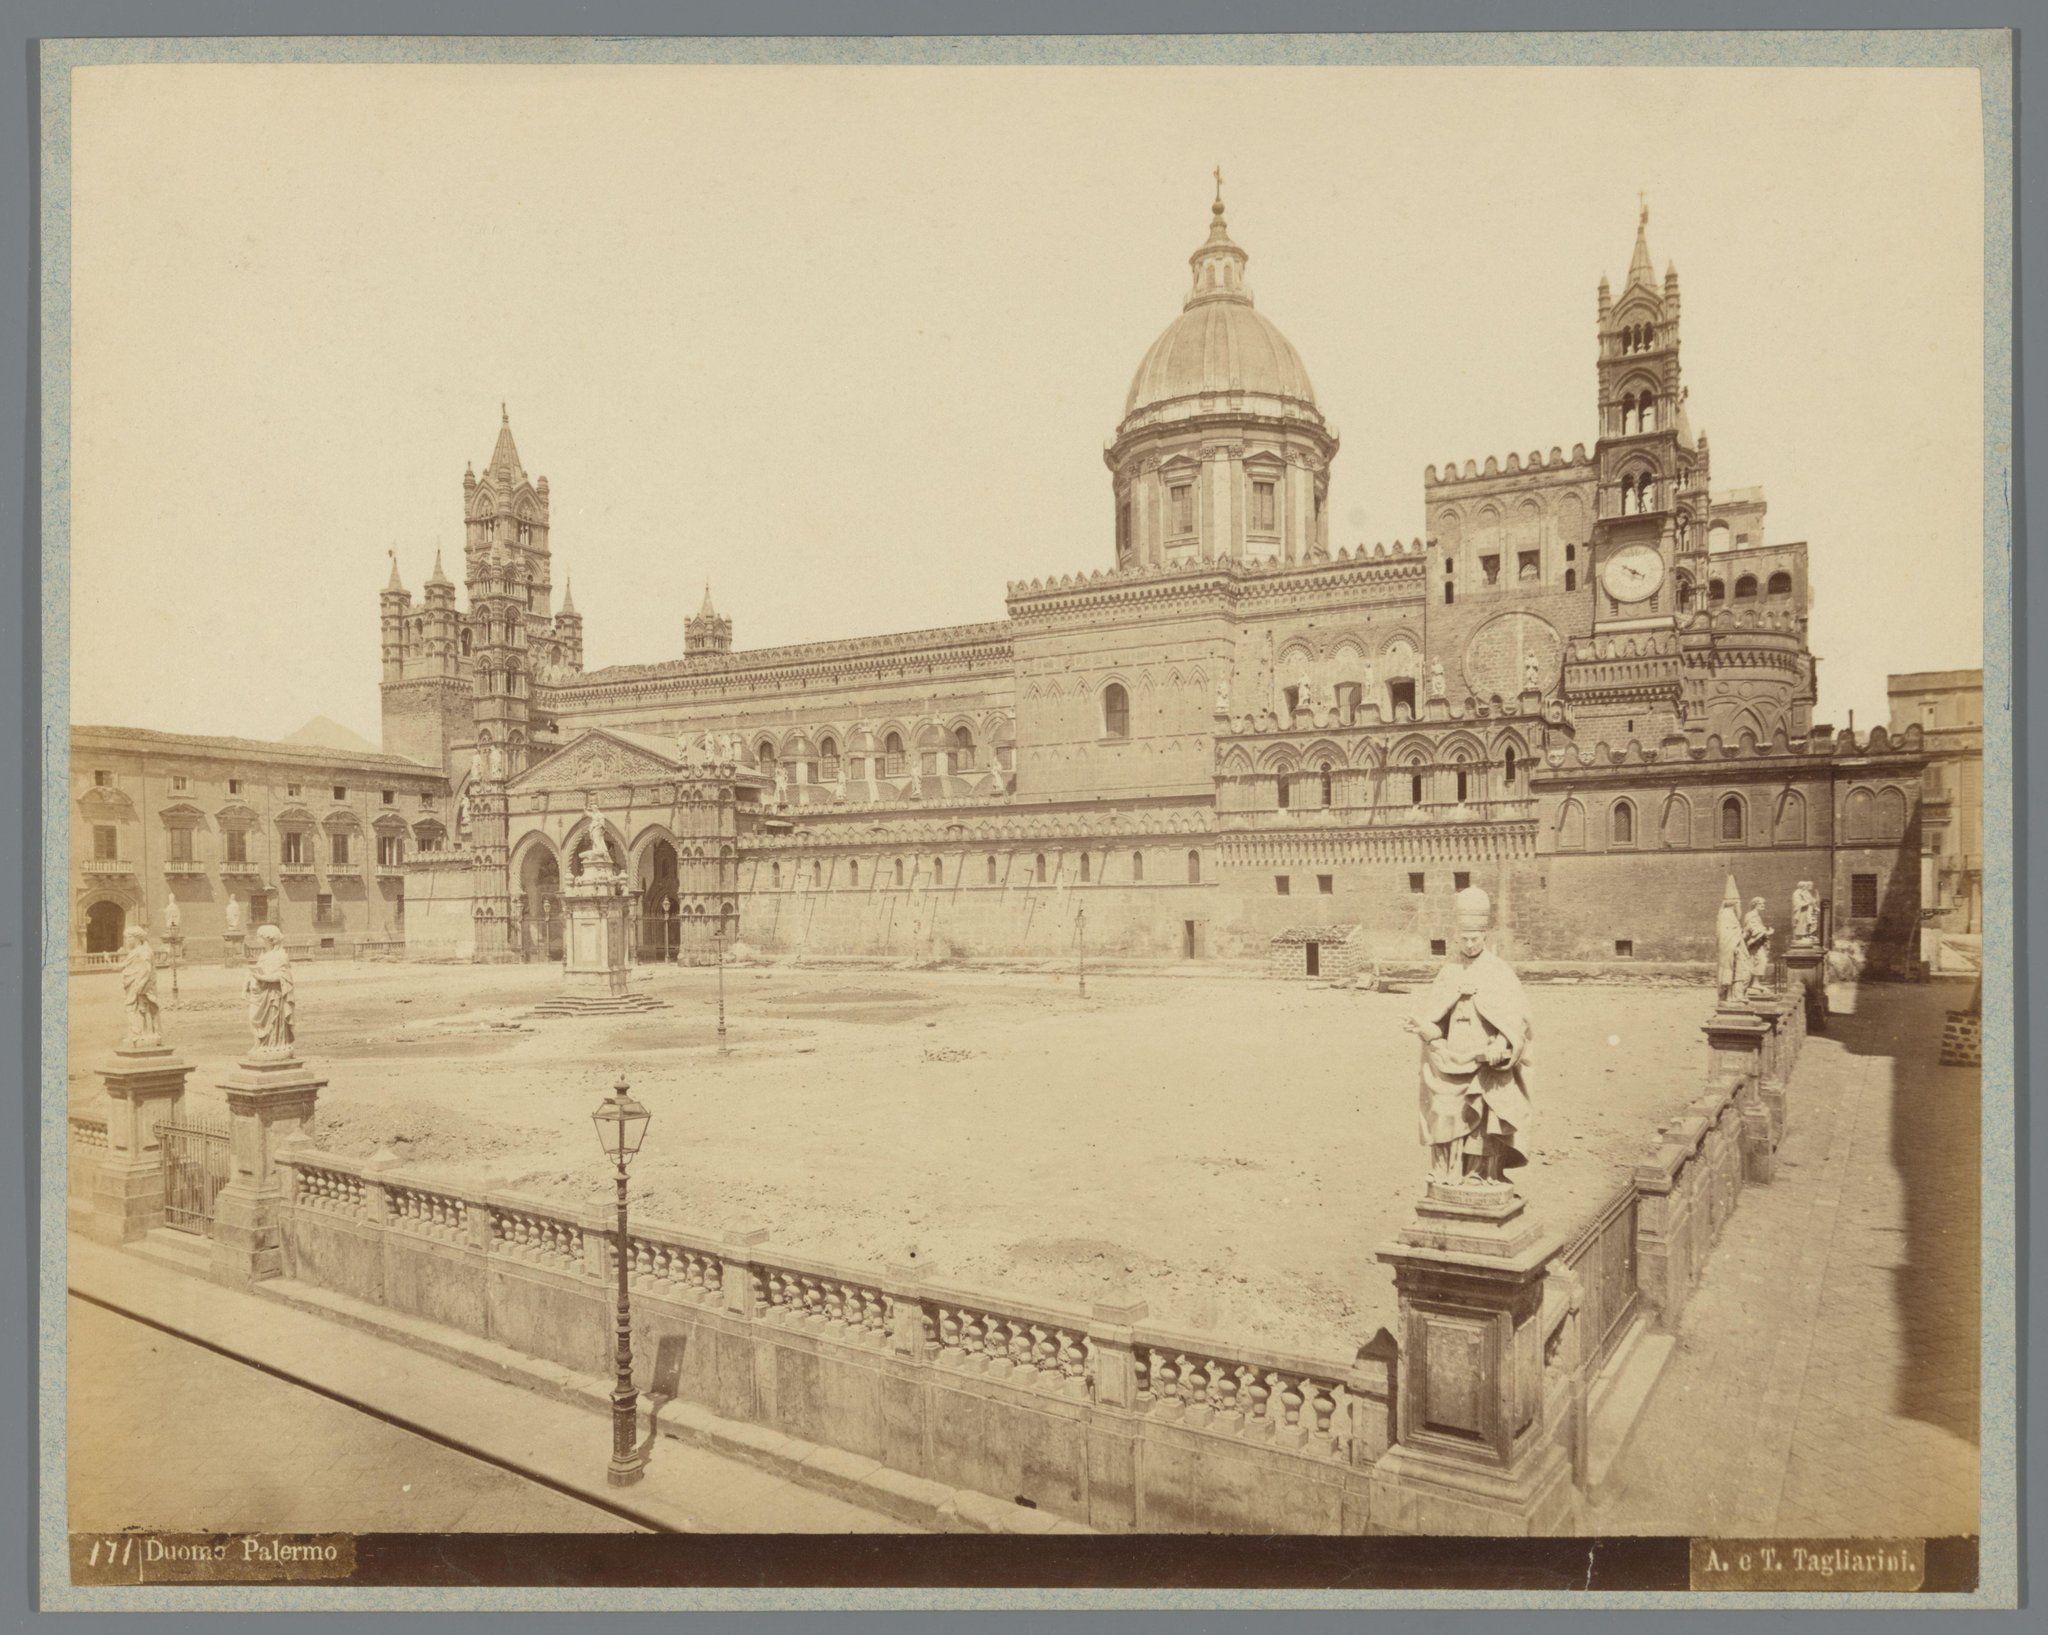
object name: photograph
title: Gezicht op de dom van Palermo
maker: a. tagliarini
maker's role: fotograaf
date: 1851-1900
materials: cardboard, paper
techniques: albumen print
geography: palermo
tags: square, place, circus, etc., church (exterior)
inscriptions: number: ‘171’